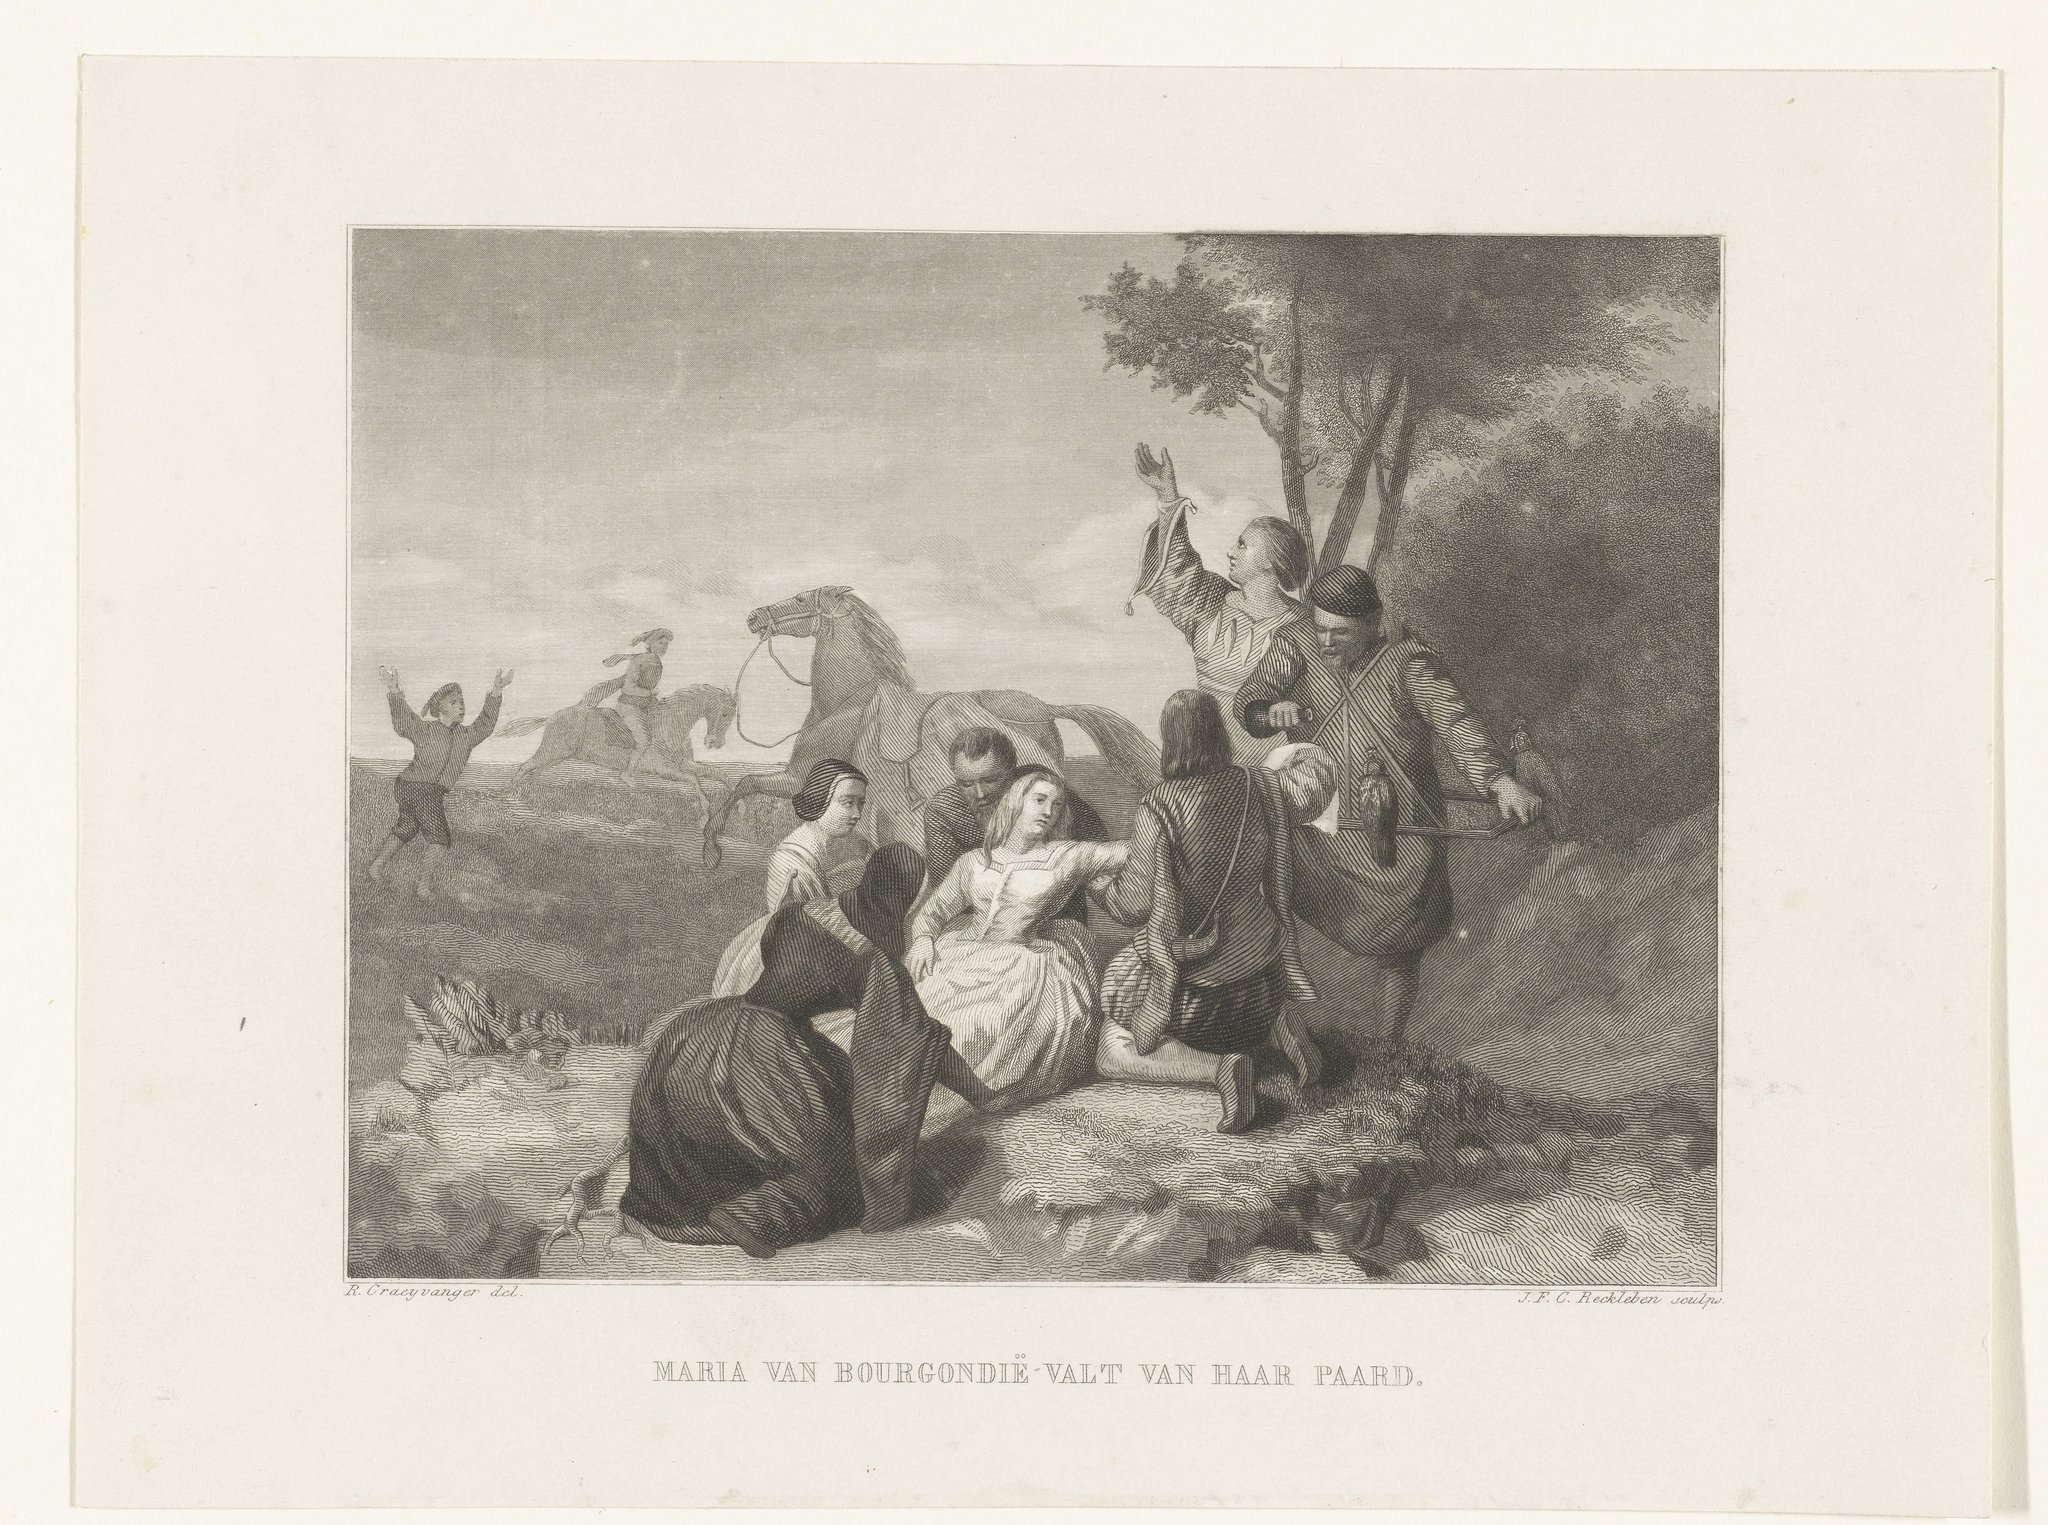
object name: print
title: Maria van Bourgondië valt van haar paard, 1482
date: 1844-1846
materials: paper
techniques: engraving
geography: netherlands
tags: maria (hertogin van bourgondië), dying from the effects of a fall, bruges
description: Illustratie voor: J.P. Arend, Algemeene geschiedenis des vaderlands, Amsterdam, 5 delen, 1840-1882, dl. 2.3, p. 76. Niet in Frederik Muller; door het RPK toegevoegd nummer.